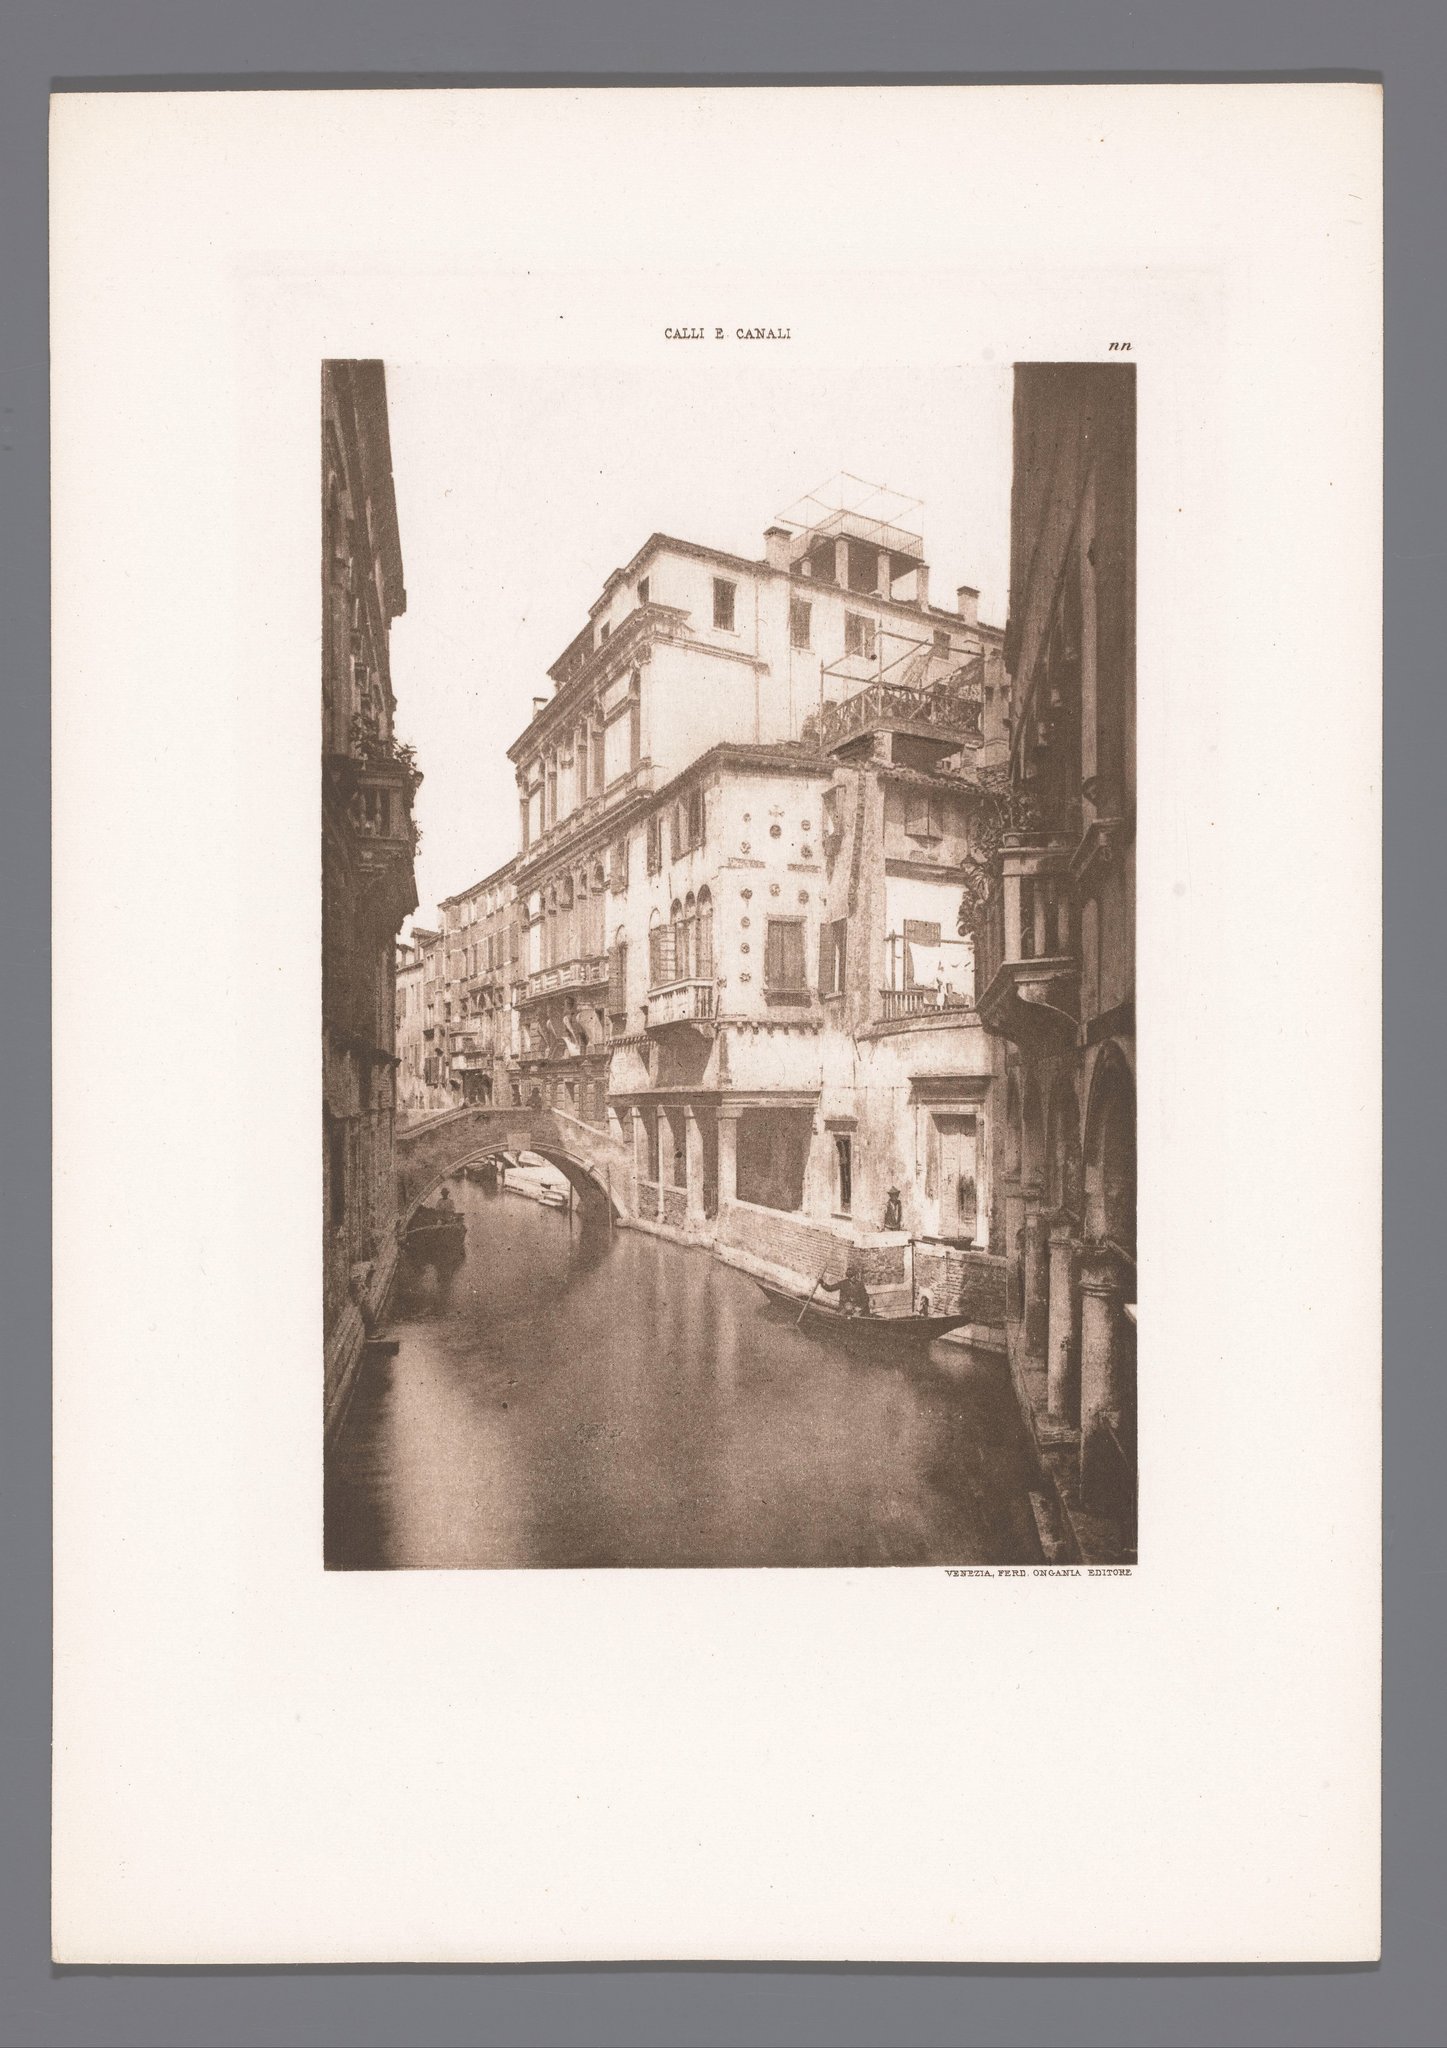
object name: page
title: Calli e canali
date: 1888-1898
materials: paper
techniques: photoaquatint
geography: venice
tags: palace, canals, waters (in city), venice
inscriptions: inscription: ‘nn’